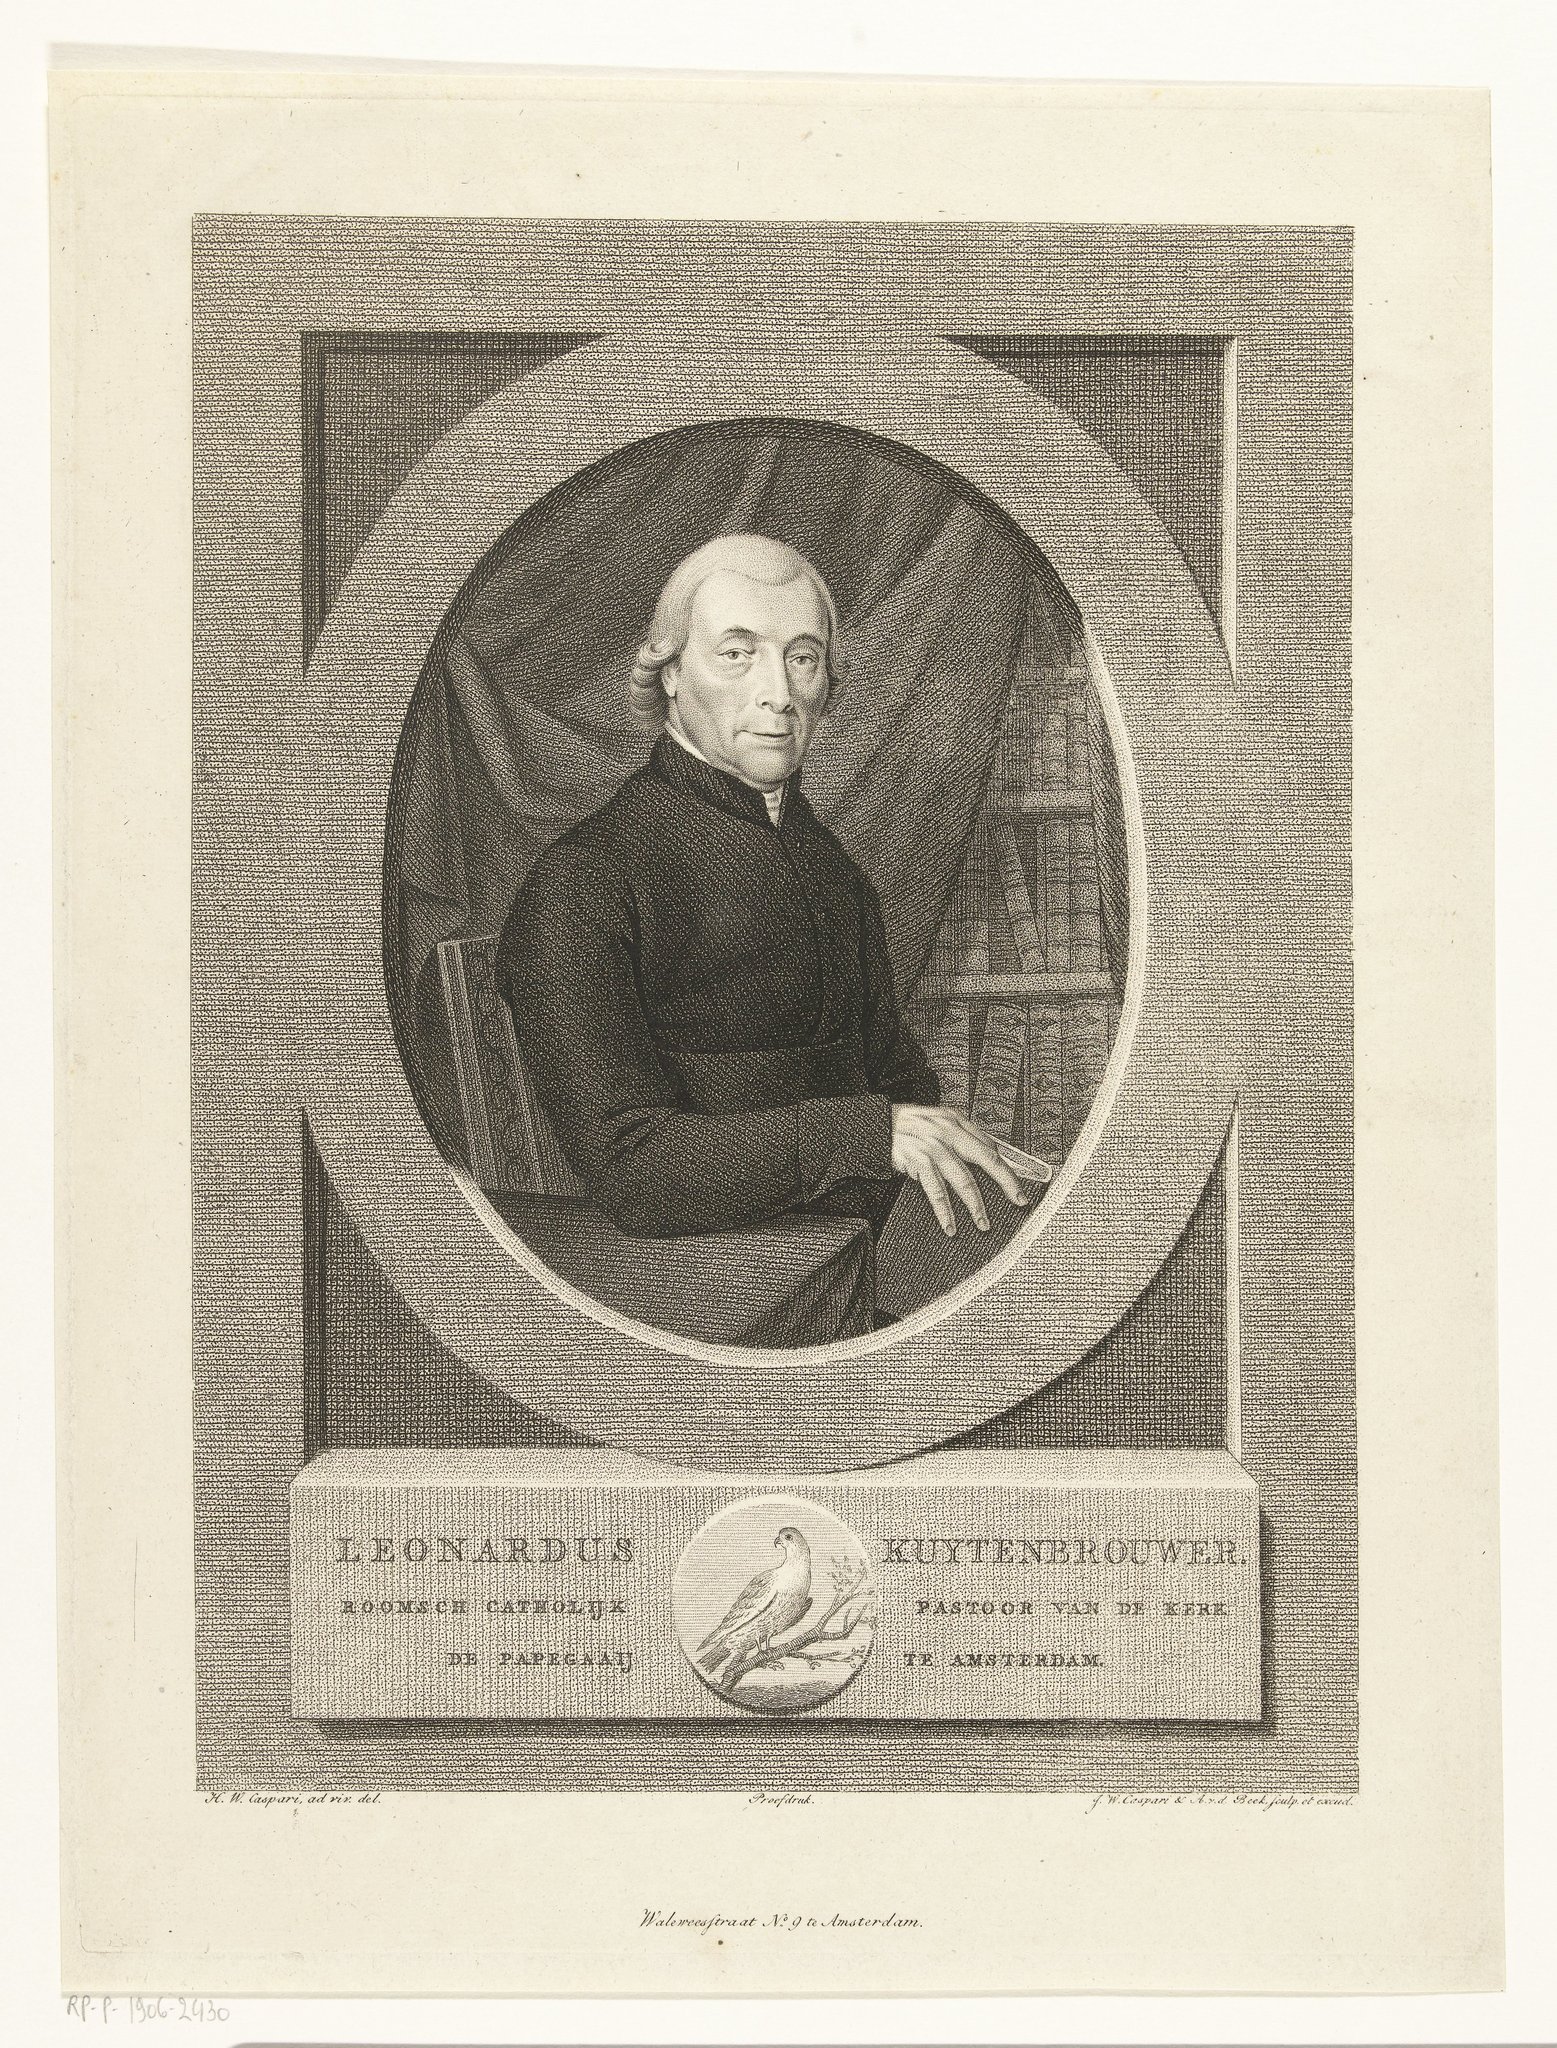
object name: print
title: Portret van Leonardus Kuytenbrouwer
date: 1789-1822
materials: paper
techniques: etching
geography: amsterdam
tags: leonardus kuytenbrouwer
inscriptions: collector's mark: Lugt 2228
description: Portret in ovale lijst van Leonardus Kuytenbrouwer, pastoor van de Petrus en Paulus-kerk (de Papegaai) te Amsterdam. Kuytenbrouwer draagt het priestersgewaad en zit achter zijn bureau met buste naar rechts. Hij heeft een boek in de rechterhand. Op de achtergrond een boekenkast. De prent heeft een Nederlands onderschrift met de naam van de geportretteerde en een cartouche met daarin de afbeelding van een papegaai.